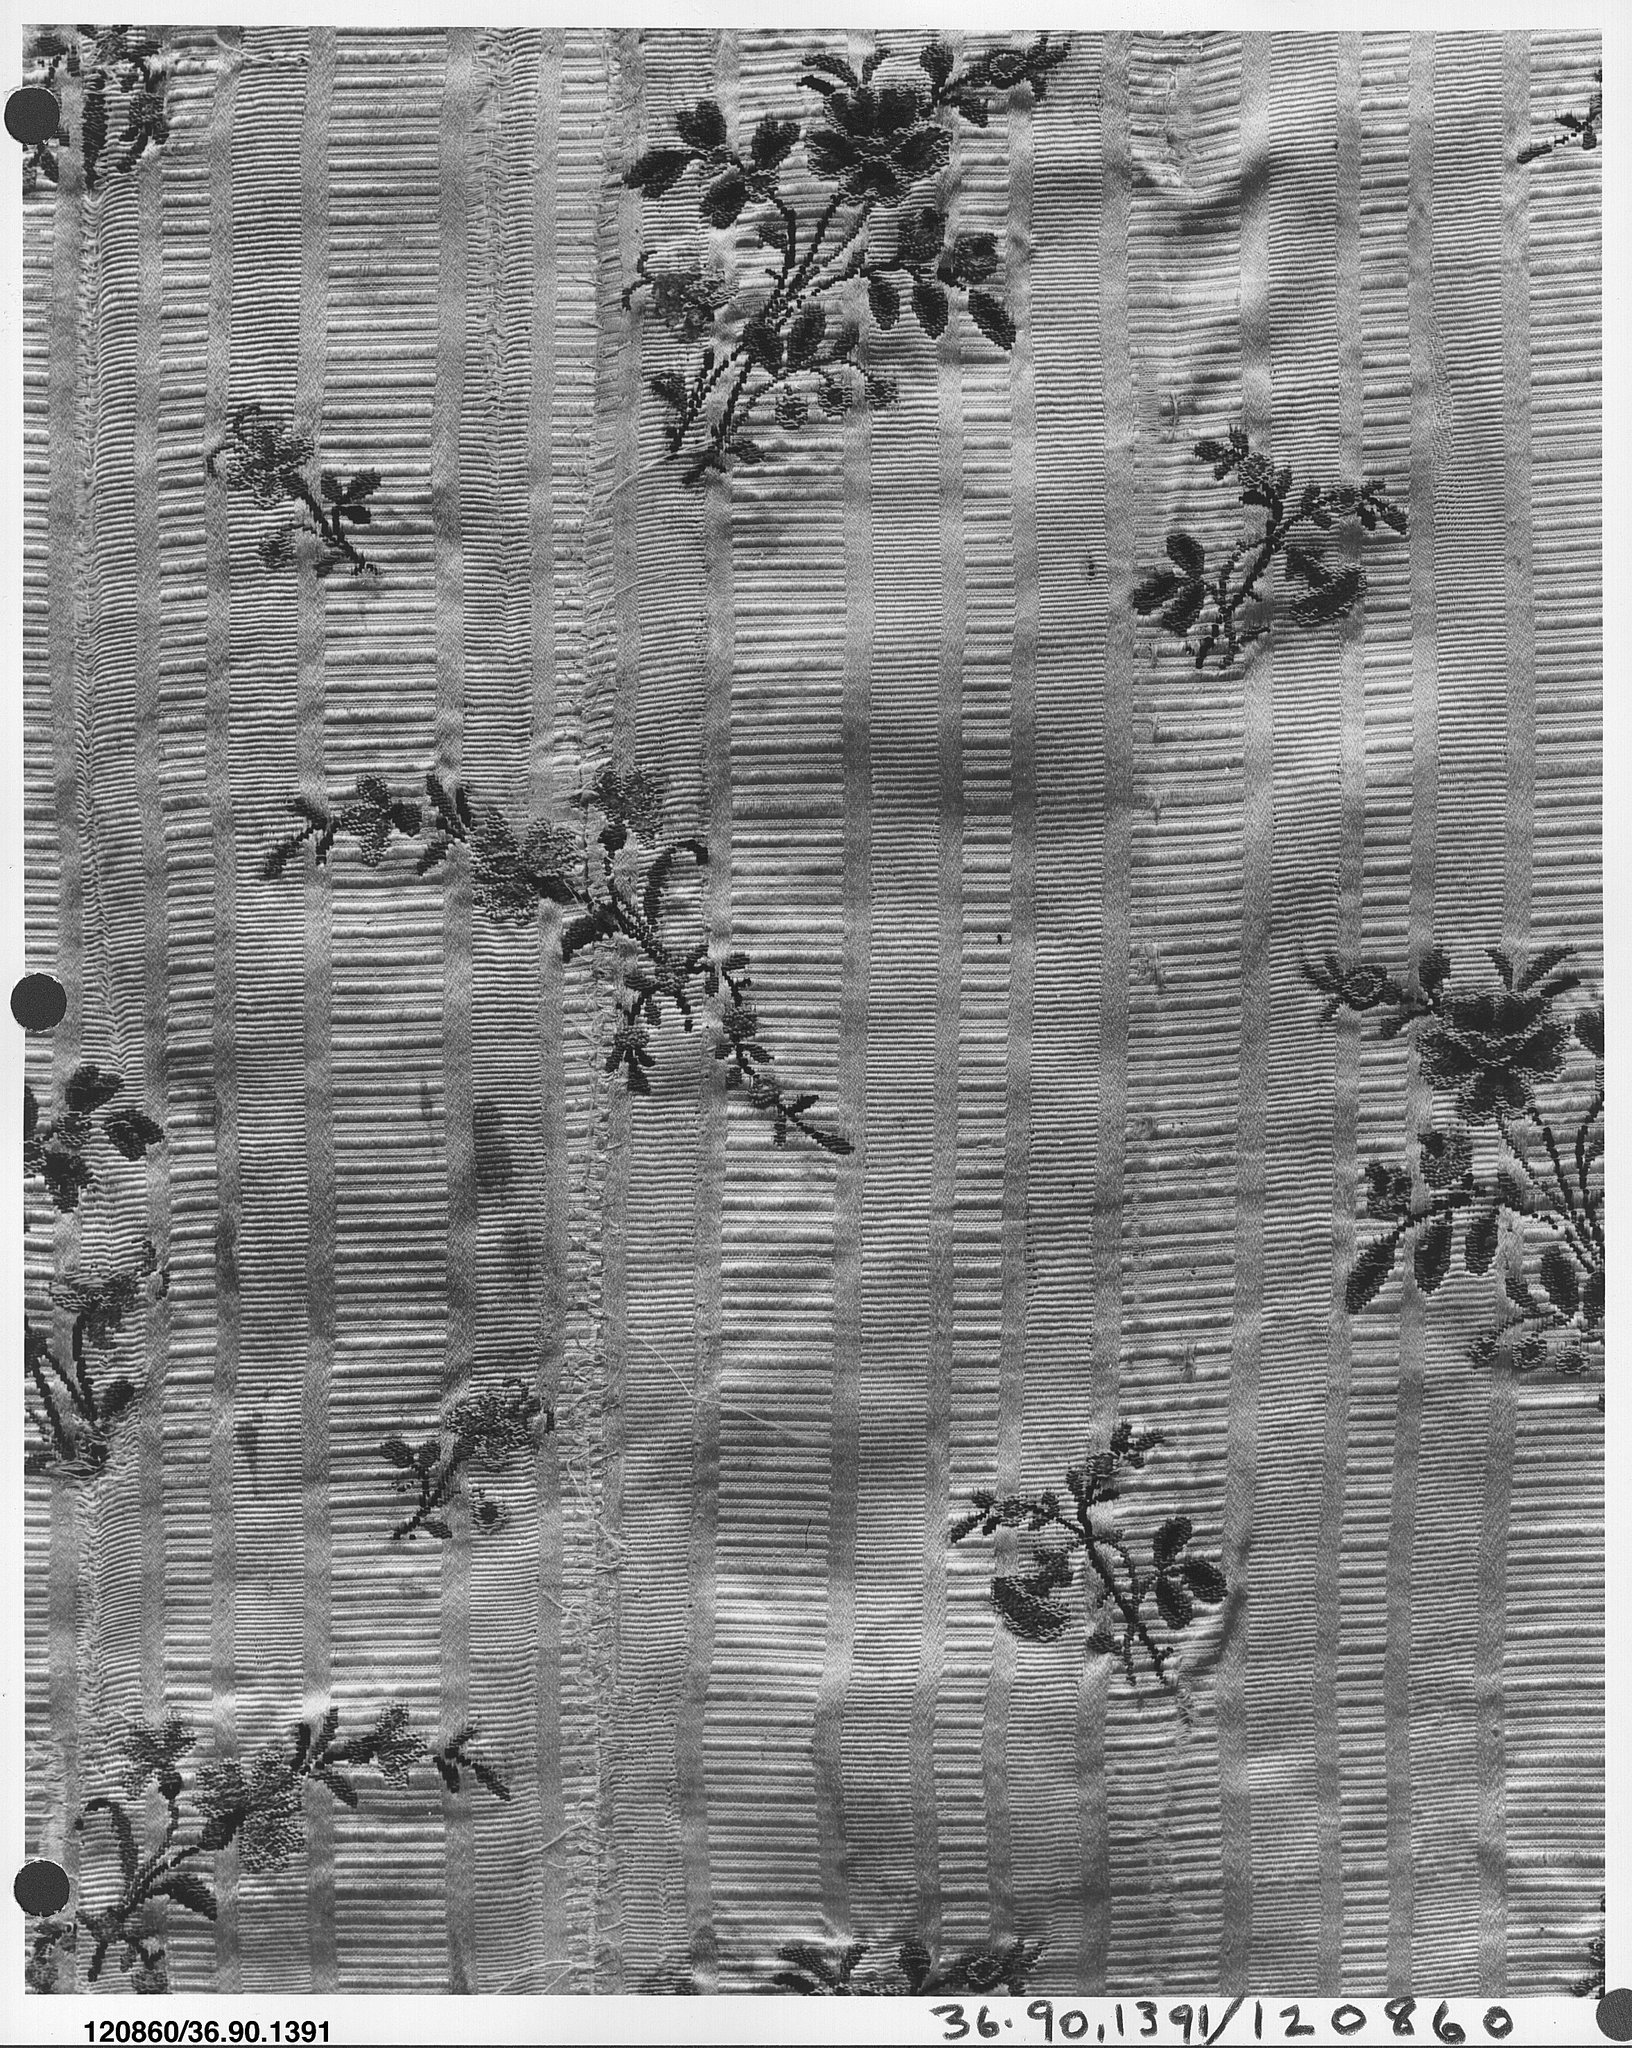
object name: piece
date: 1701-1800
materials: silk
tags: flowers,leaves